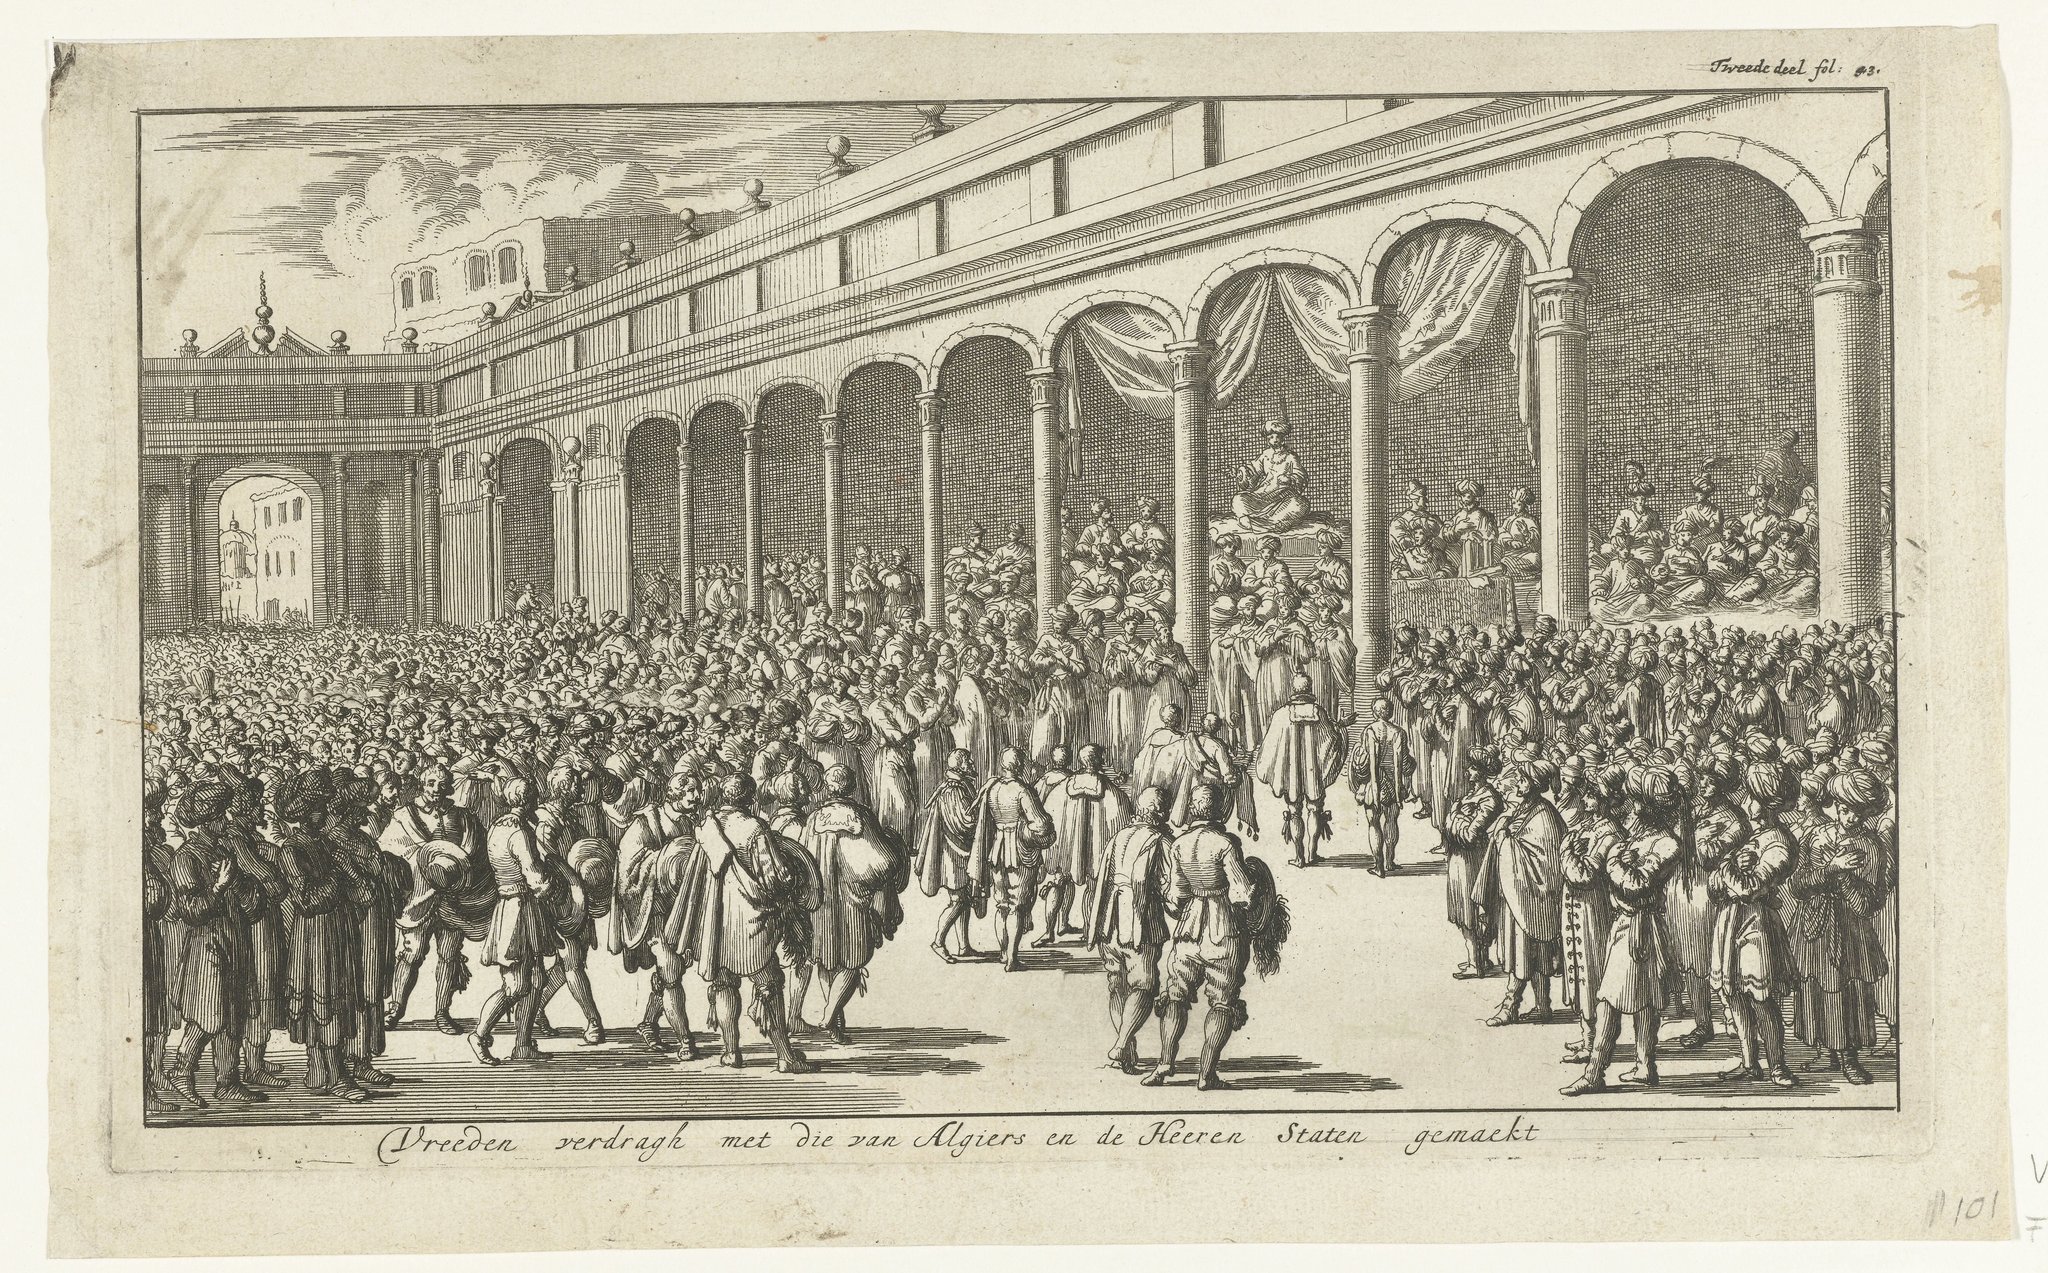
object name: print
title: Vredesverdrag gesloten met de Algerijnen, 1623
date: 1684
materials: paper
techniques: engraving, etching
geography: amsterdam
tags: cornelis pijnacker, pirate, corsair, buccaneer, square, place, circus, etc., peace negotiations, slavery; serfs and enslaved persons, ruler, sovereign, signing of peace treaty, concluding the peace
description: Prent uit: Vries, Simon de. Handelingen en geschiedenissen voorgevallen tusschen den Staet der Vereenighde Nederlanden en dien van de zee-roovers in Barbaryen (...). Amsterdam: Jan Claesz ten Hoorn, 1684, p. 43. Uitgegeven als het tweede deel van: Dan, Pierre. Historie van Barbaryen, en des zelfs zee-roovers (...). 2 dln. Amsterdam: Jan Claesz ten Hoorn, 1684. Muller plaatst deze gebeurtenis in 1623, maar het vond plaats in 1622.